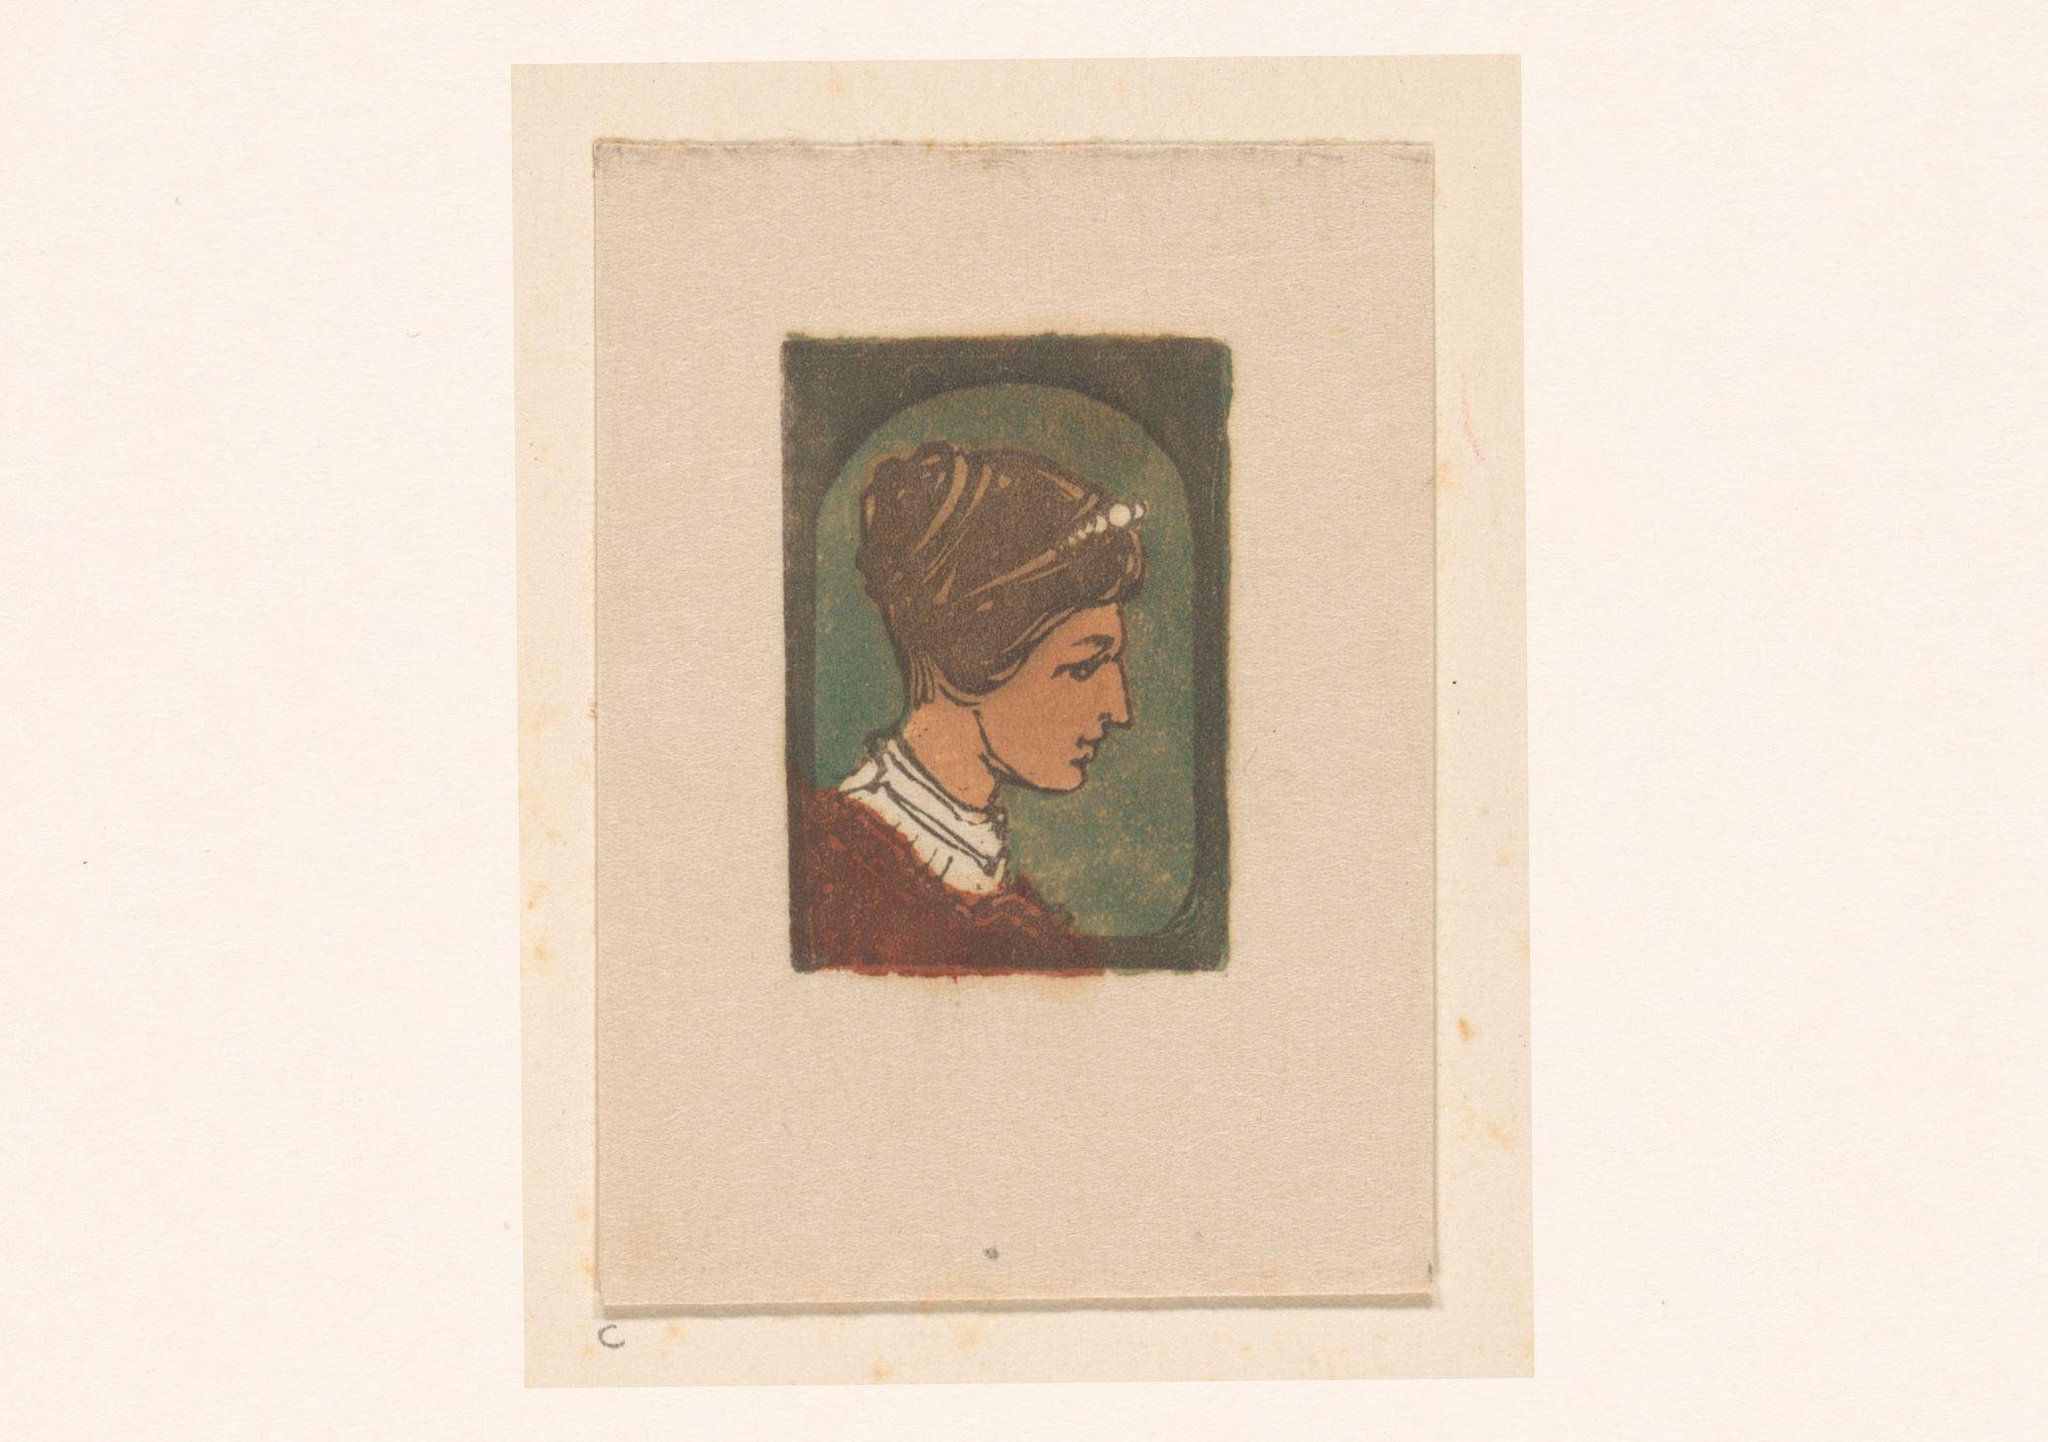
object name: print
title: Hoofd van een vrouw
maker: bernard willem wierink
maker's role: draughtsman, print maker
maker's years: 1856-1939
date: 1866-1939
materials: paper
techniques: relief print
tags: anonymous historical person portrayed - bb - woman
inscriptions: collector's mark: Lugt 2228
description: Deze prent is vermoedelijk een plaatsnede, ook al wordt in de literatuur veelal gesproken over een houtsnede. Voor zover Wierink zijn prenten in hoogdruk zelf nader heeft omschreven, heeft hij altijd de term 'plaatsnede' gebruikt.